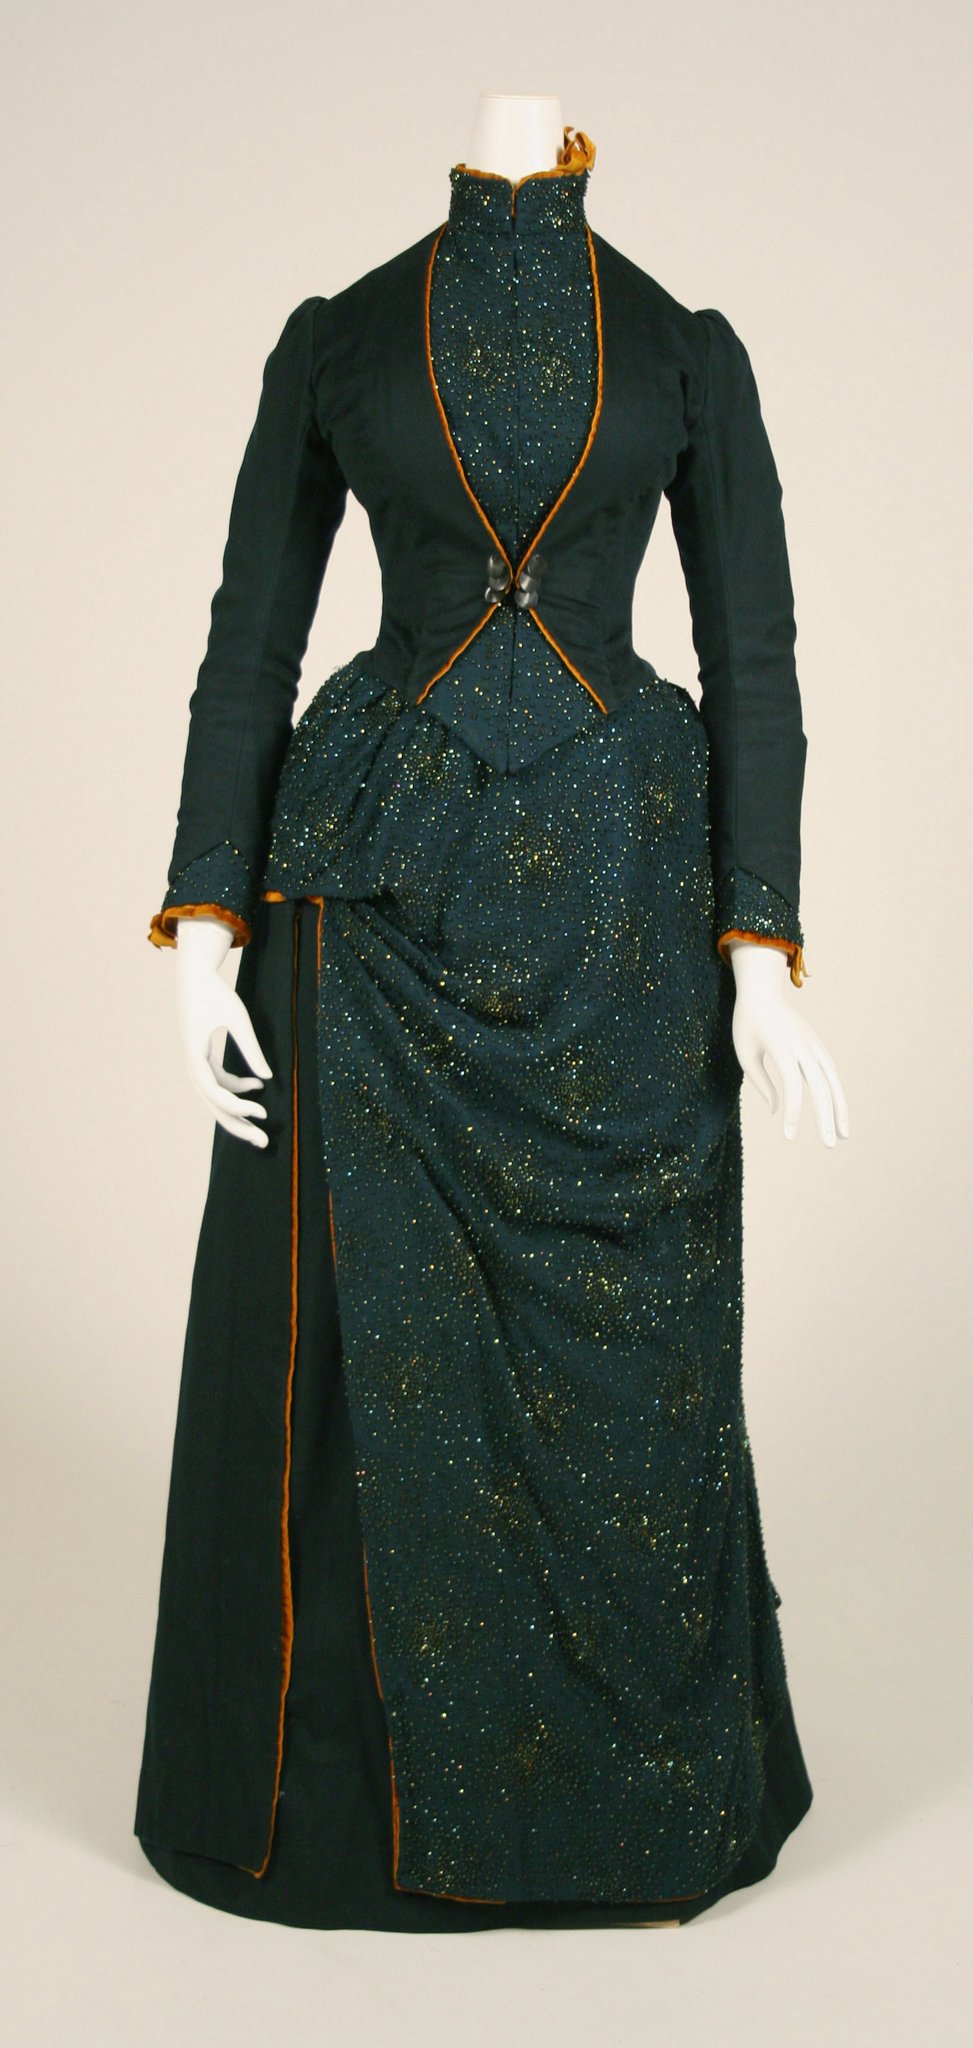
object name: ensemble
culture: american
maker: catherine donovan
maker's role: designer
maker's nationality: american, born ireland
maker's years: 1826-1906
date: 1887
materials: feather, glass, silk, wool